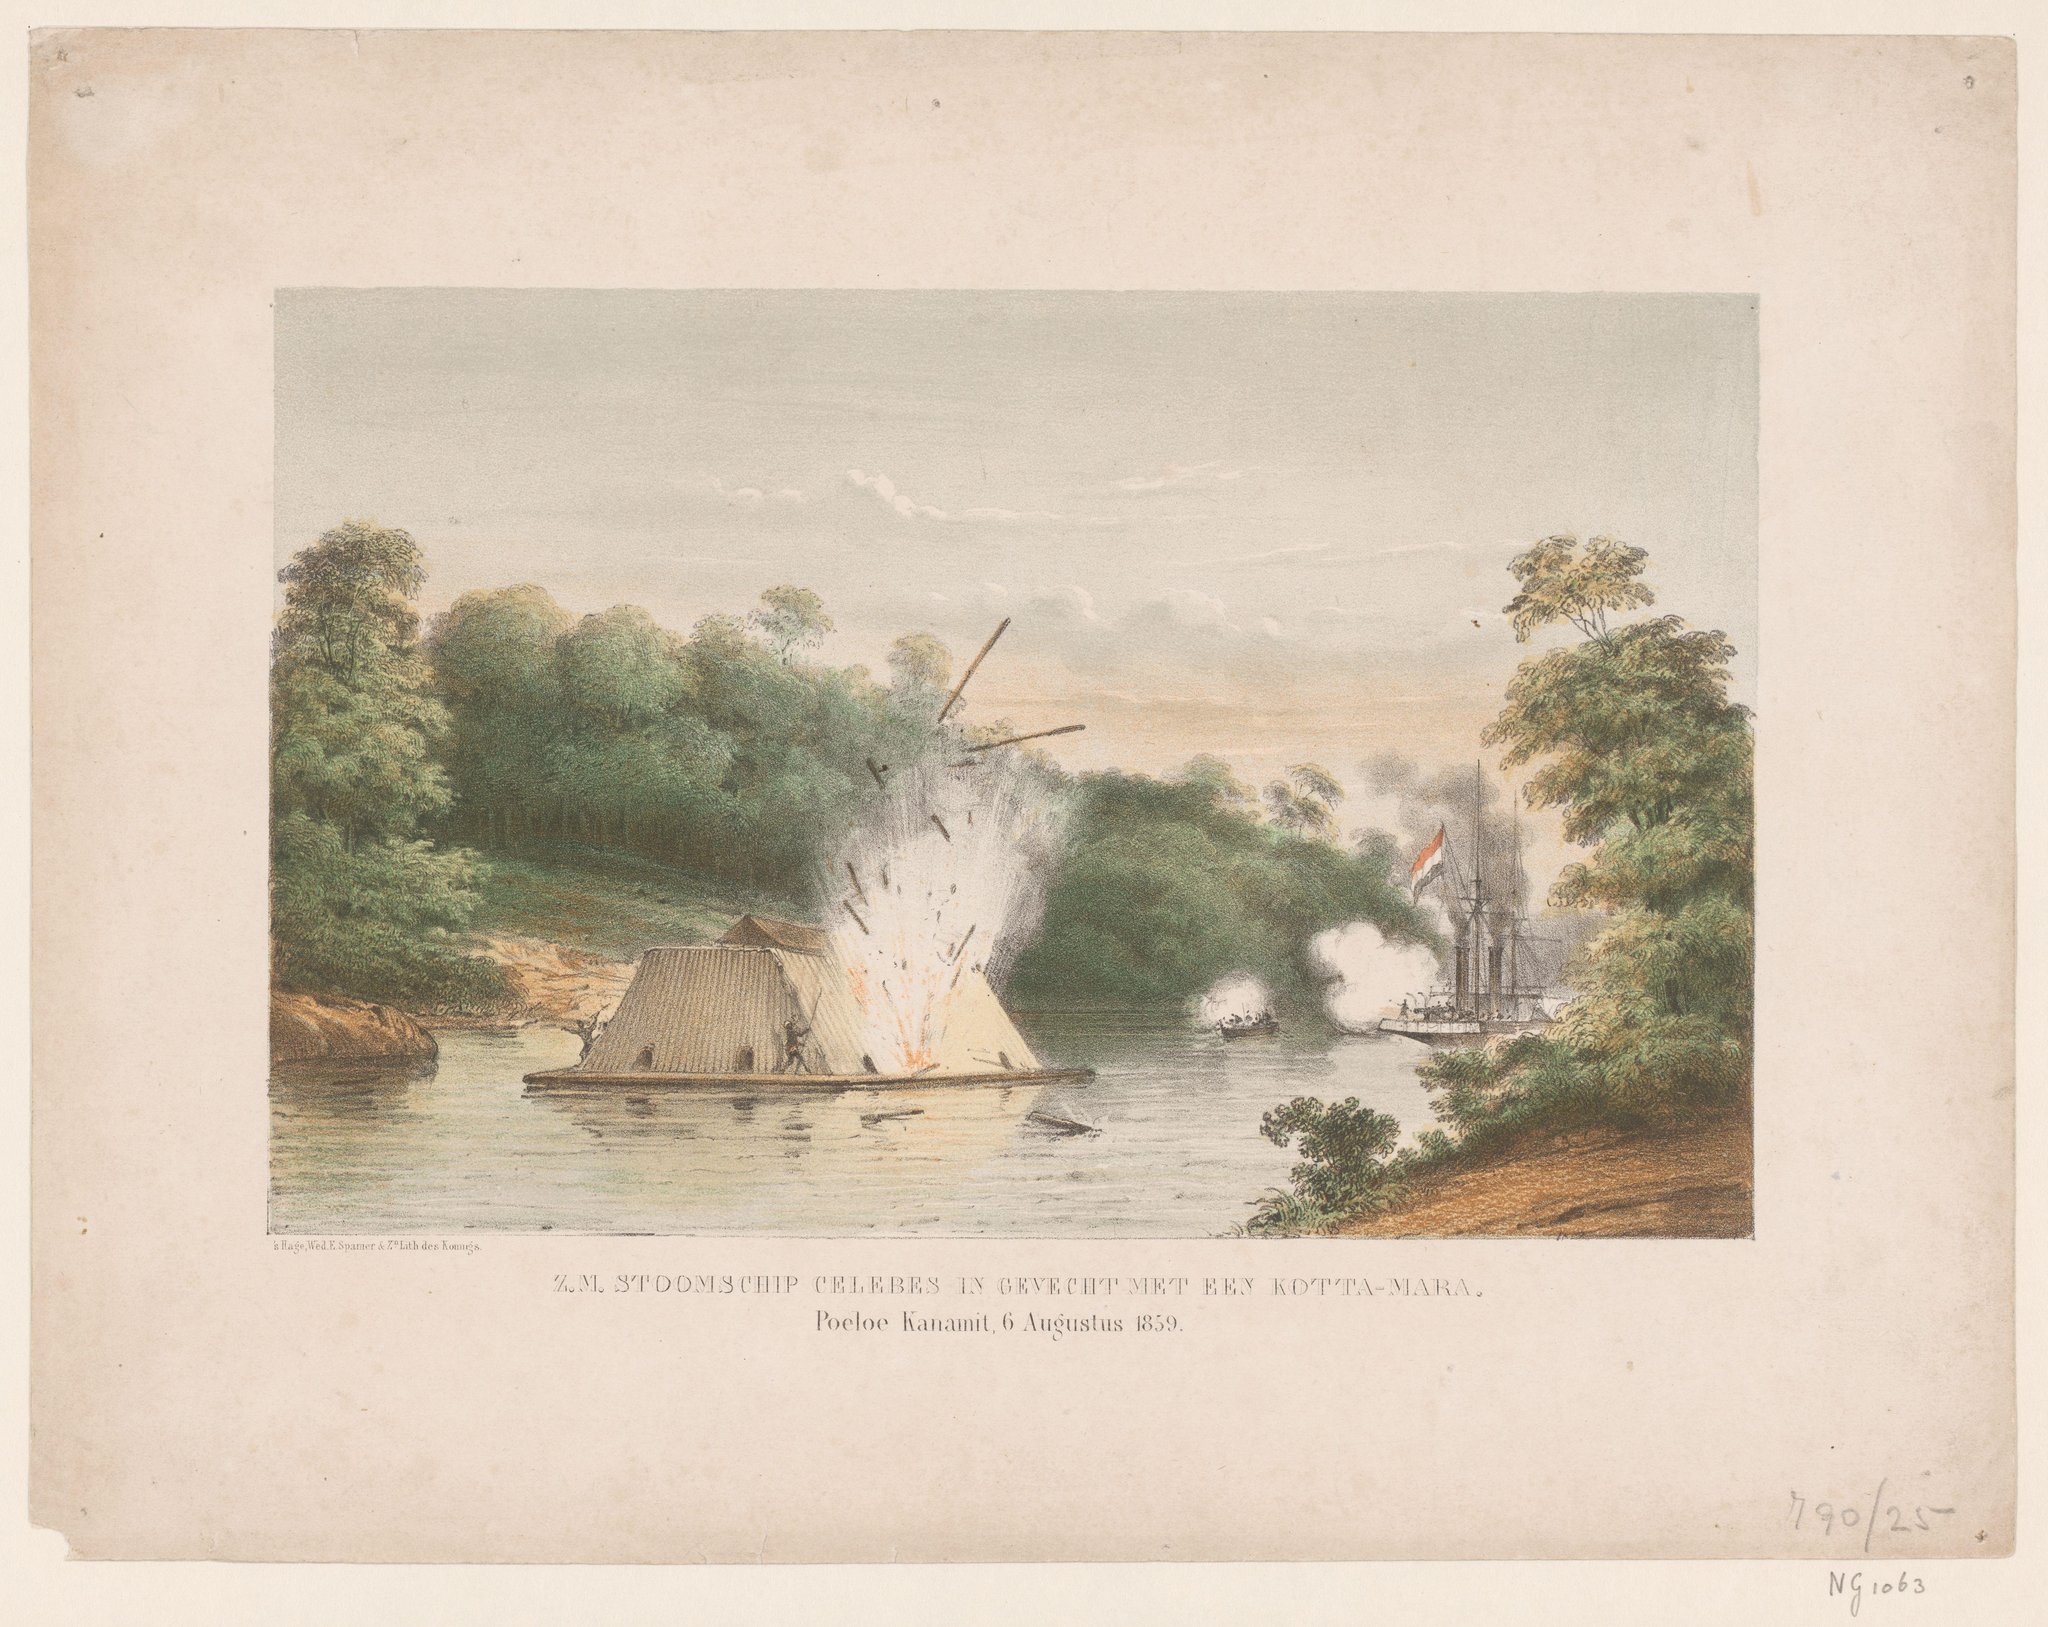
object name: print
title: Z.M. Stoomschip Celebes in gevecht met een kotta-mara. Poeloe Kanamit, 6 Augustus 1859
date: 1865-1867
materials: paper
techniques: lithograph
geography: the hague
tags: battle (+ naval force), steamship, motorship, borneo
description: Het raderstoomschip Z.M. Celebes in gevecht met een zgn. kotta-mara bij Pulau Kanamit op Borneo tijdens de Bandjarmasinse oorlog, 6 augustus 1859. Rivierlandschap met een kotta-mara op het water met twee inlandse mannen aan boord. Het schip wordt getroffen door de beschieting door het stoomschip Celebes die de Nederlandse vlag voert en een sloep, waarvan rookwolken (van geschut) opstijgen.